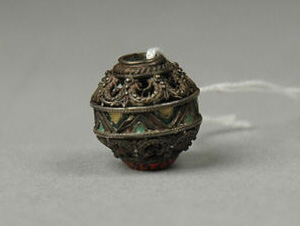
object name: ojime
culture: japanese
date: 1801-1900